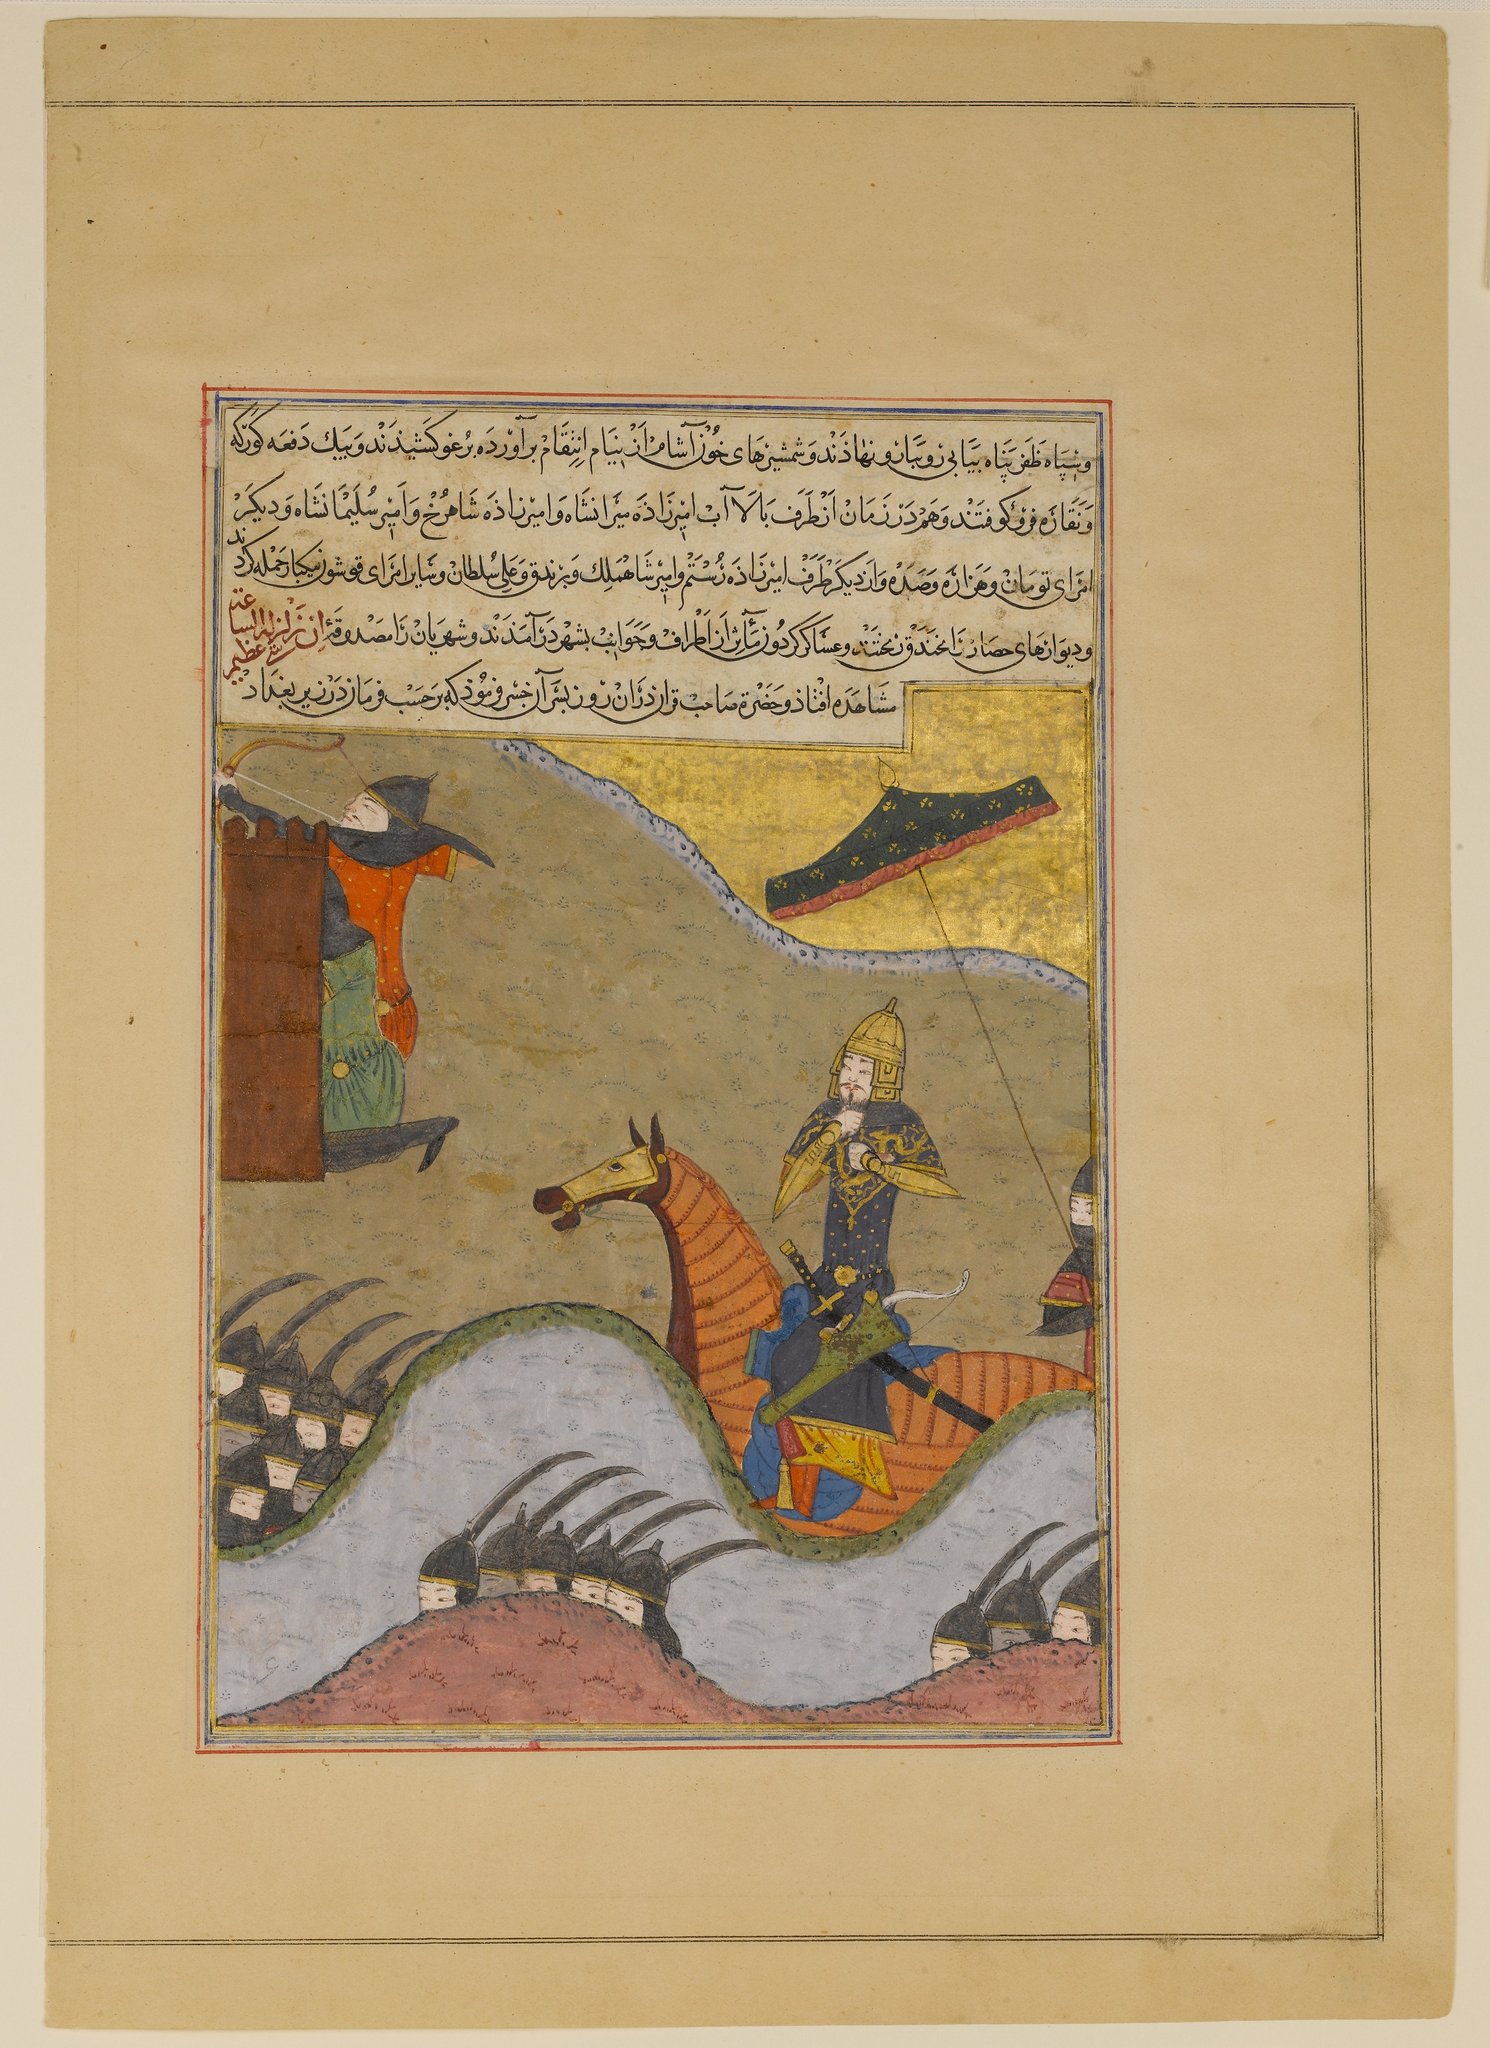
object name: folio from an illustrated manuscript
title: "Conquest of Baghdad by Timur", Folio from a Zafarnama (Book of Victory)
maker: sharaf al-din 'ali yazdi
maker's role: author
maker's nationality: iranian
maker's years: 1370-1454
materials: gold, ink, paper, watercolor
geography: iran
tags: men,horses